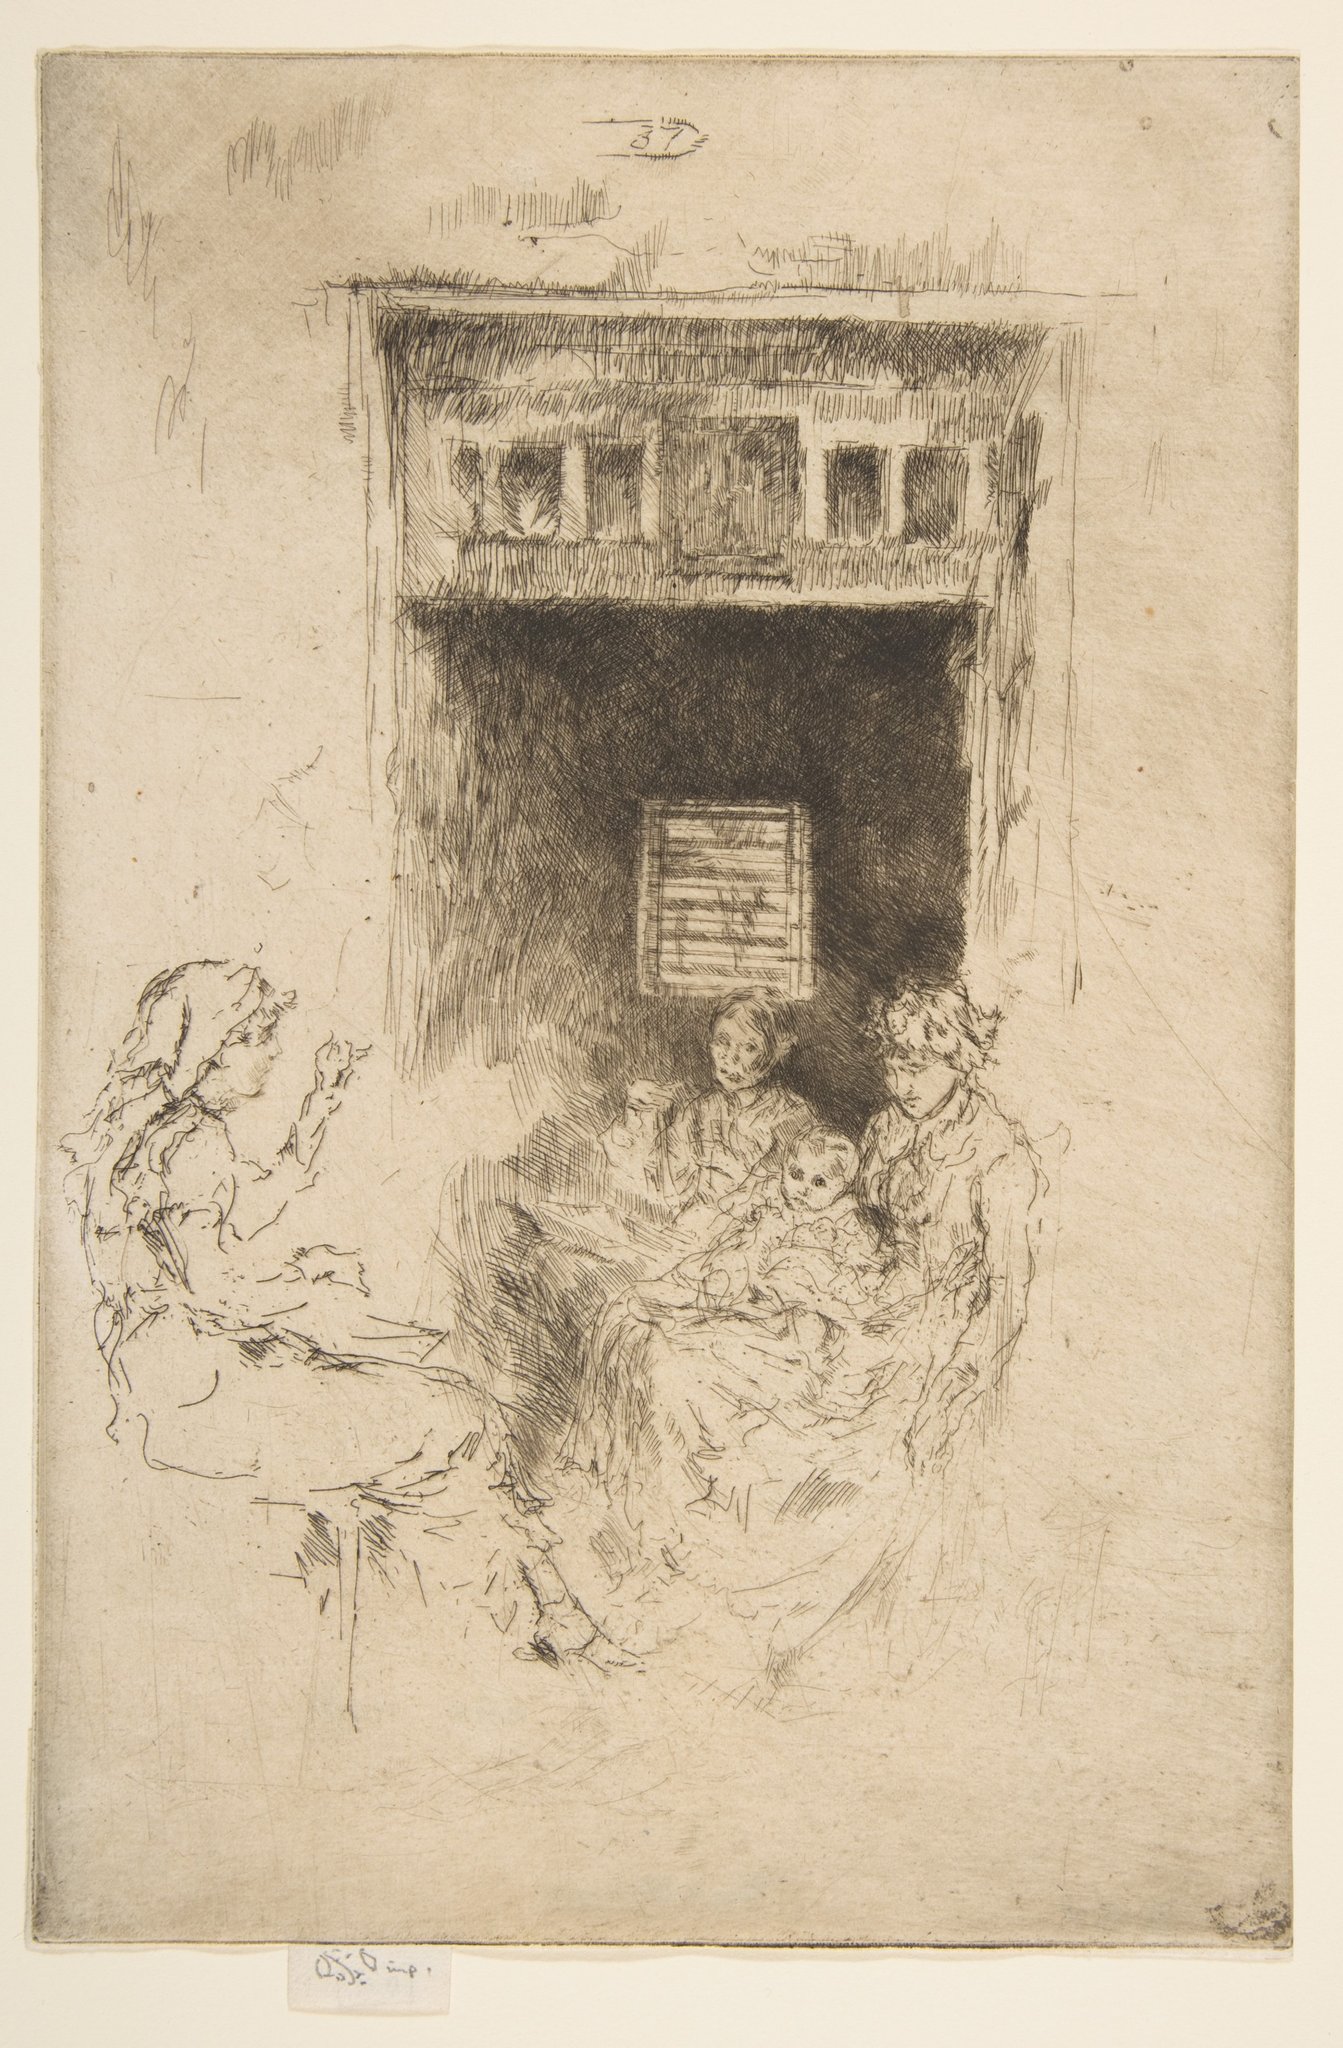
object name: print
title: Bead Stringers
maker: james mcneill whistler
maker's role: artist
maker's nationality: american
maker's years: 1834-1903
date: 1879-1880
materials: ink, paper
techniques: drypoint, etching, printing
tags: infants,women,venice